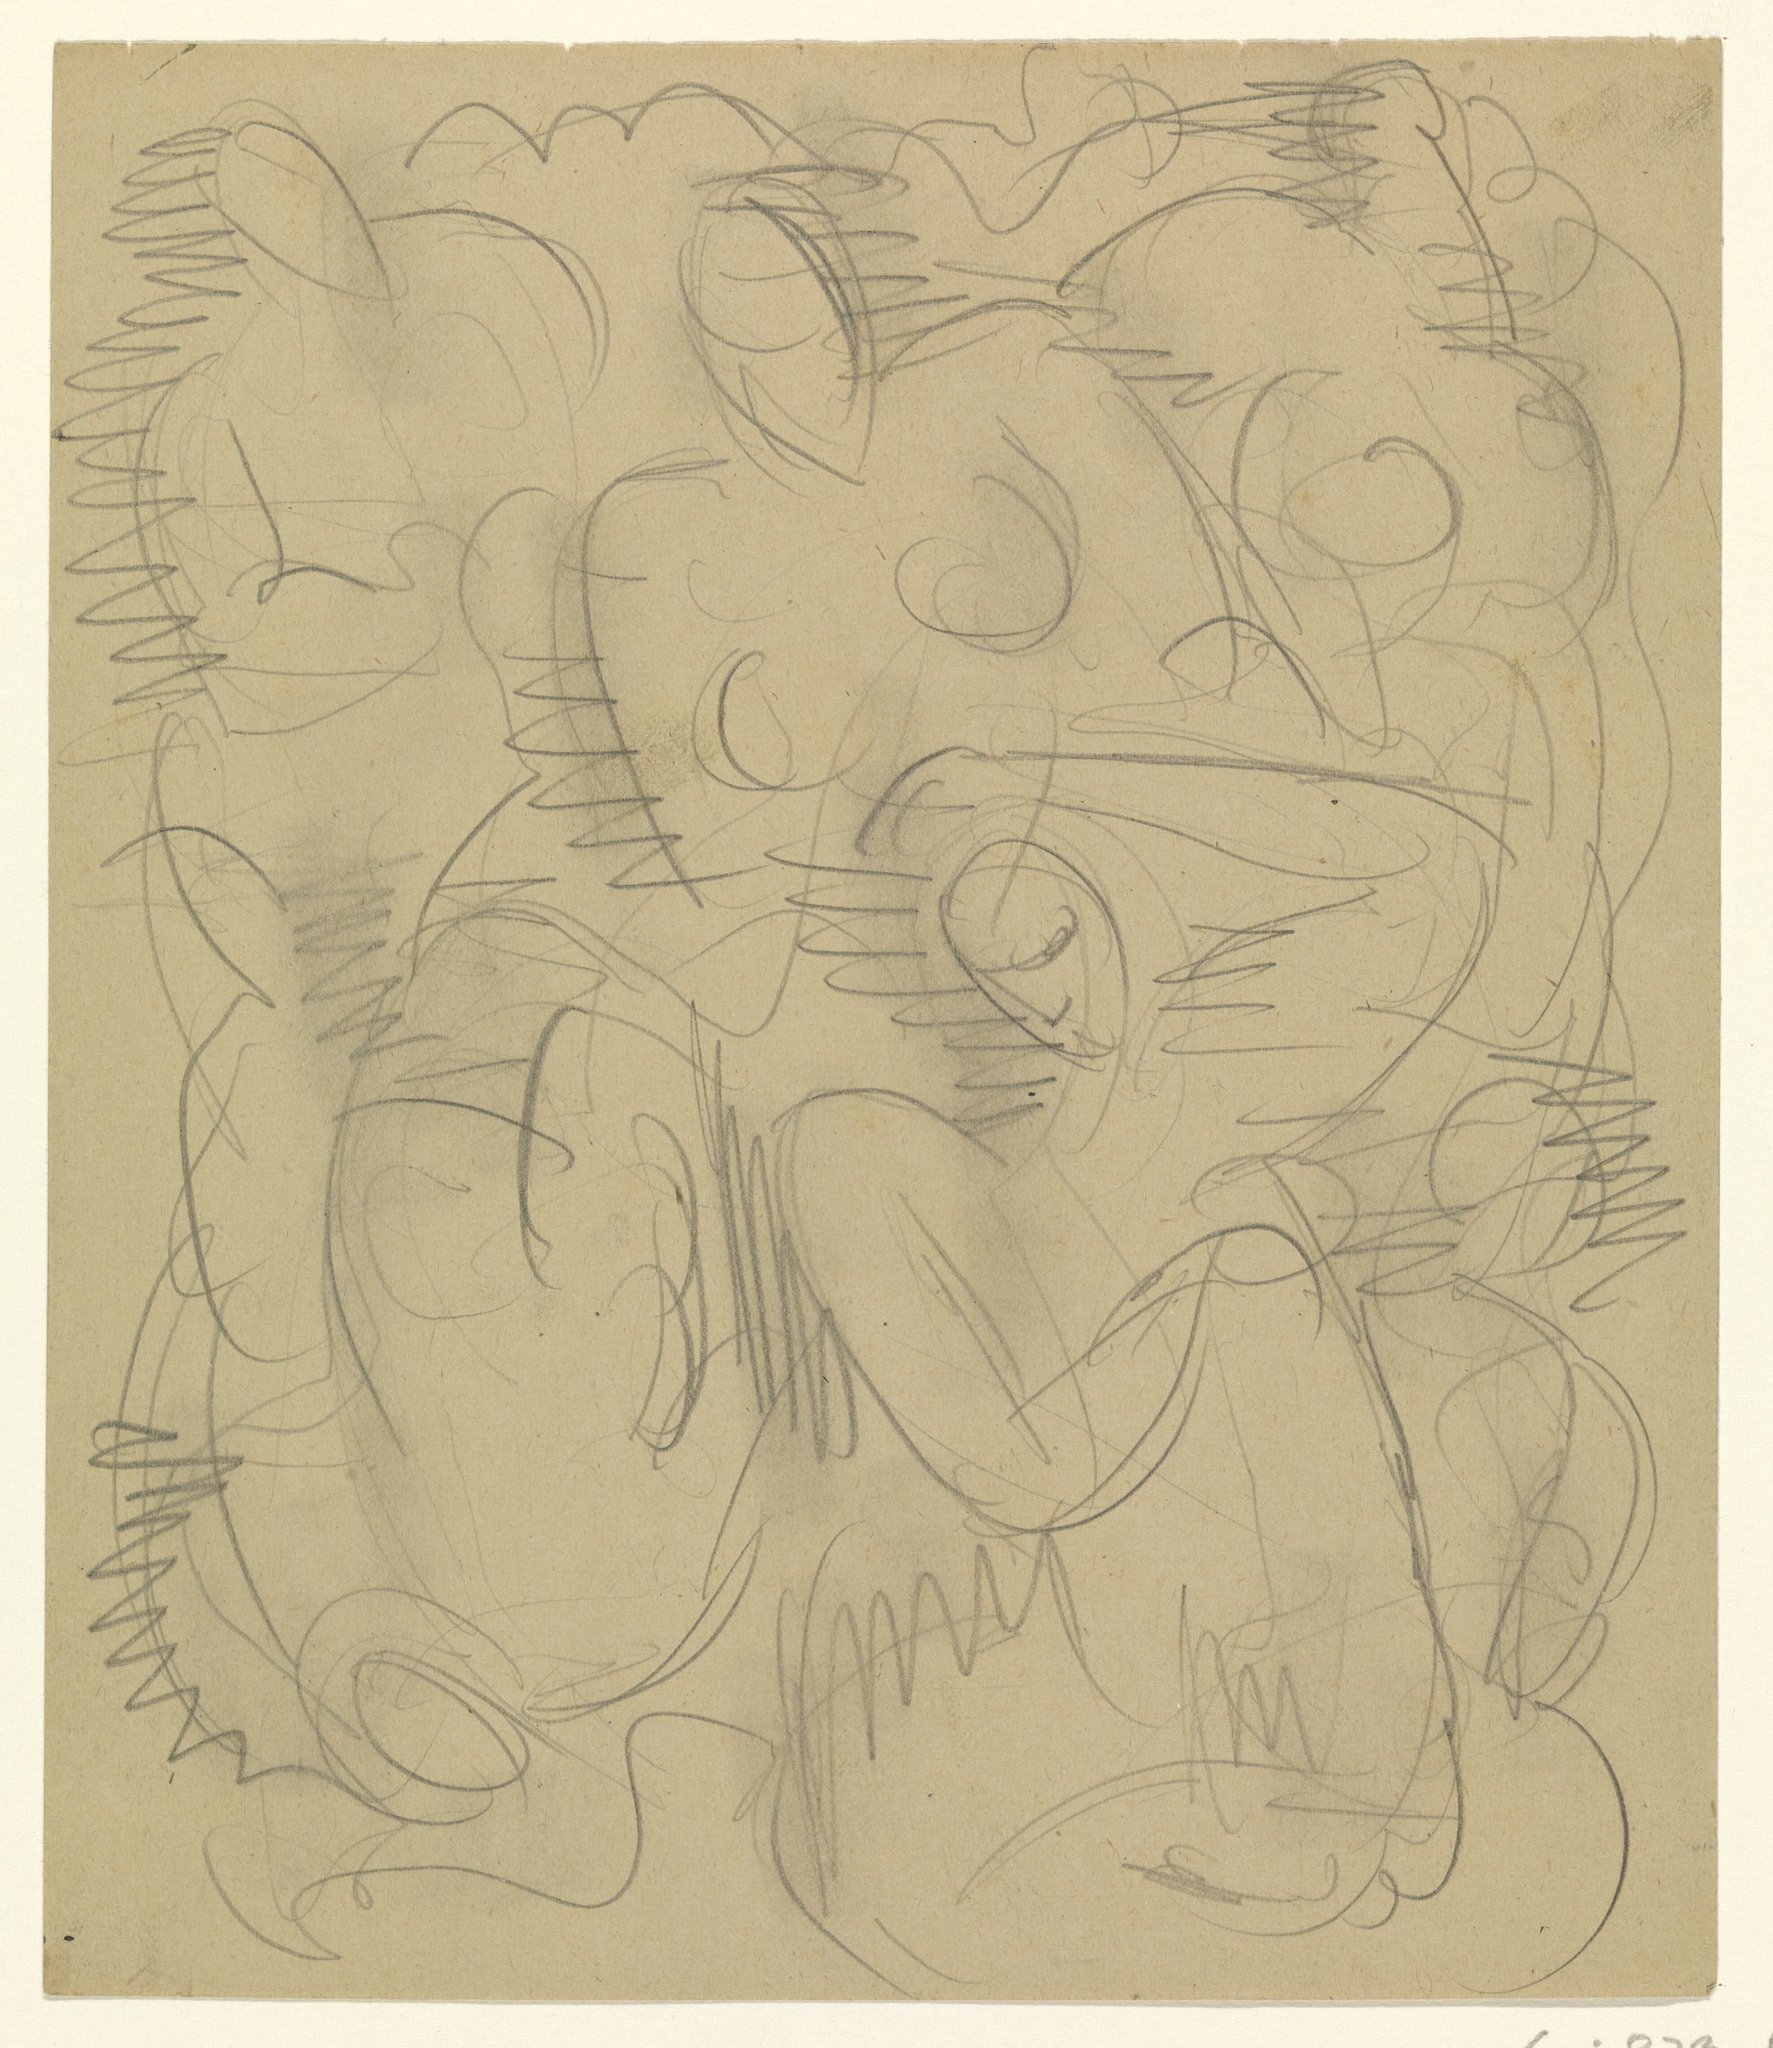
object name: drawing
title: Mensen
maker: leo gestel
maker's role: draughtsman, print maker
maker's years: 1881-1941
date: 1891-1941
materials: paper, pencil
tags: the (nude) human figure; 'corpo humano' (ripa)